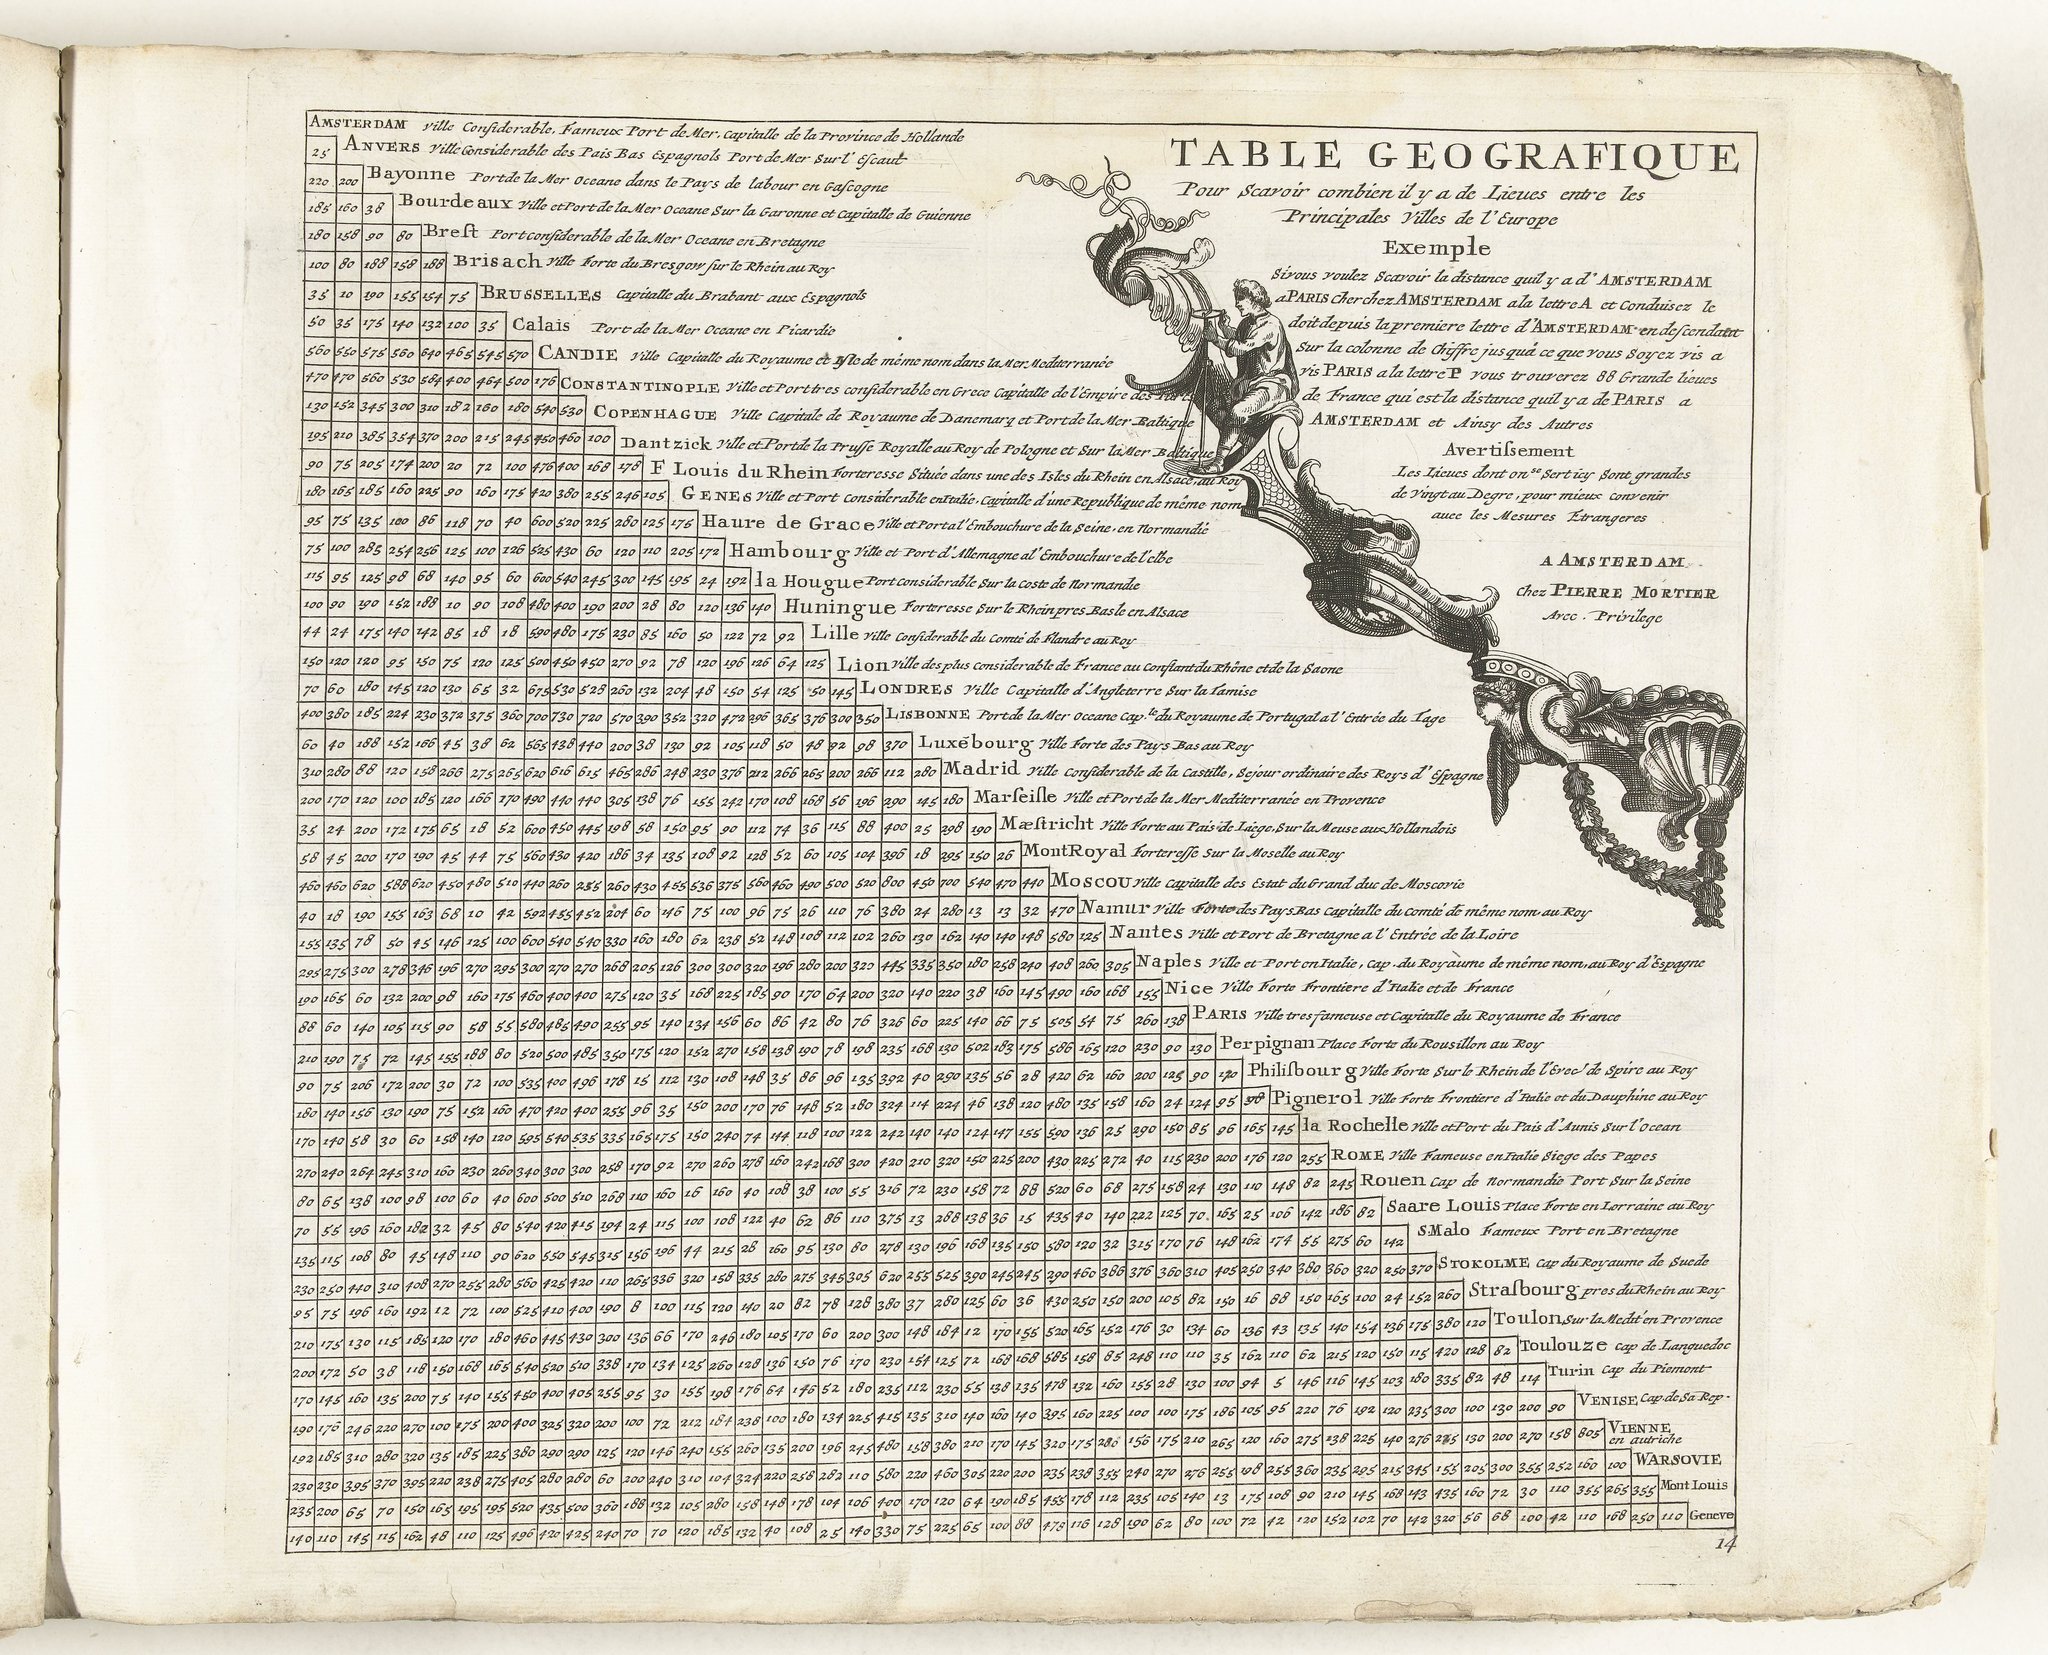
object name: print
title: Afstandentabel tussen de voornaamste Europese steden, ca. 1702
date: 1702-1703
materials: paper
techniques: etching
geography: amsterdam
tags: statistic diagram, graph; pictorial chart, etc.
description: Afstandentabel tussen de voornaamste Europese steden. Plaat nr. 14 in het prentwerk bestaande in totaal uit 276 genummerde platen van vermaarde sterke steden en vestingen in het kader van de Spaanse Successieoorlog. Voor het merendeel zijn deze platen gekopieerd naar de anonieme Franse platen: in Les forces de l'Europe en in: Le theatre de la guerre, dans les Pays-Bas, beide oorspronkelijk uitgegeven door Nicolas de Fer te Parijs (1693-1697) in het kader van de Negenjarige Oorlog. Titel en opschriften in het Frans.